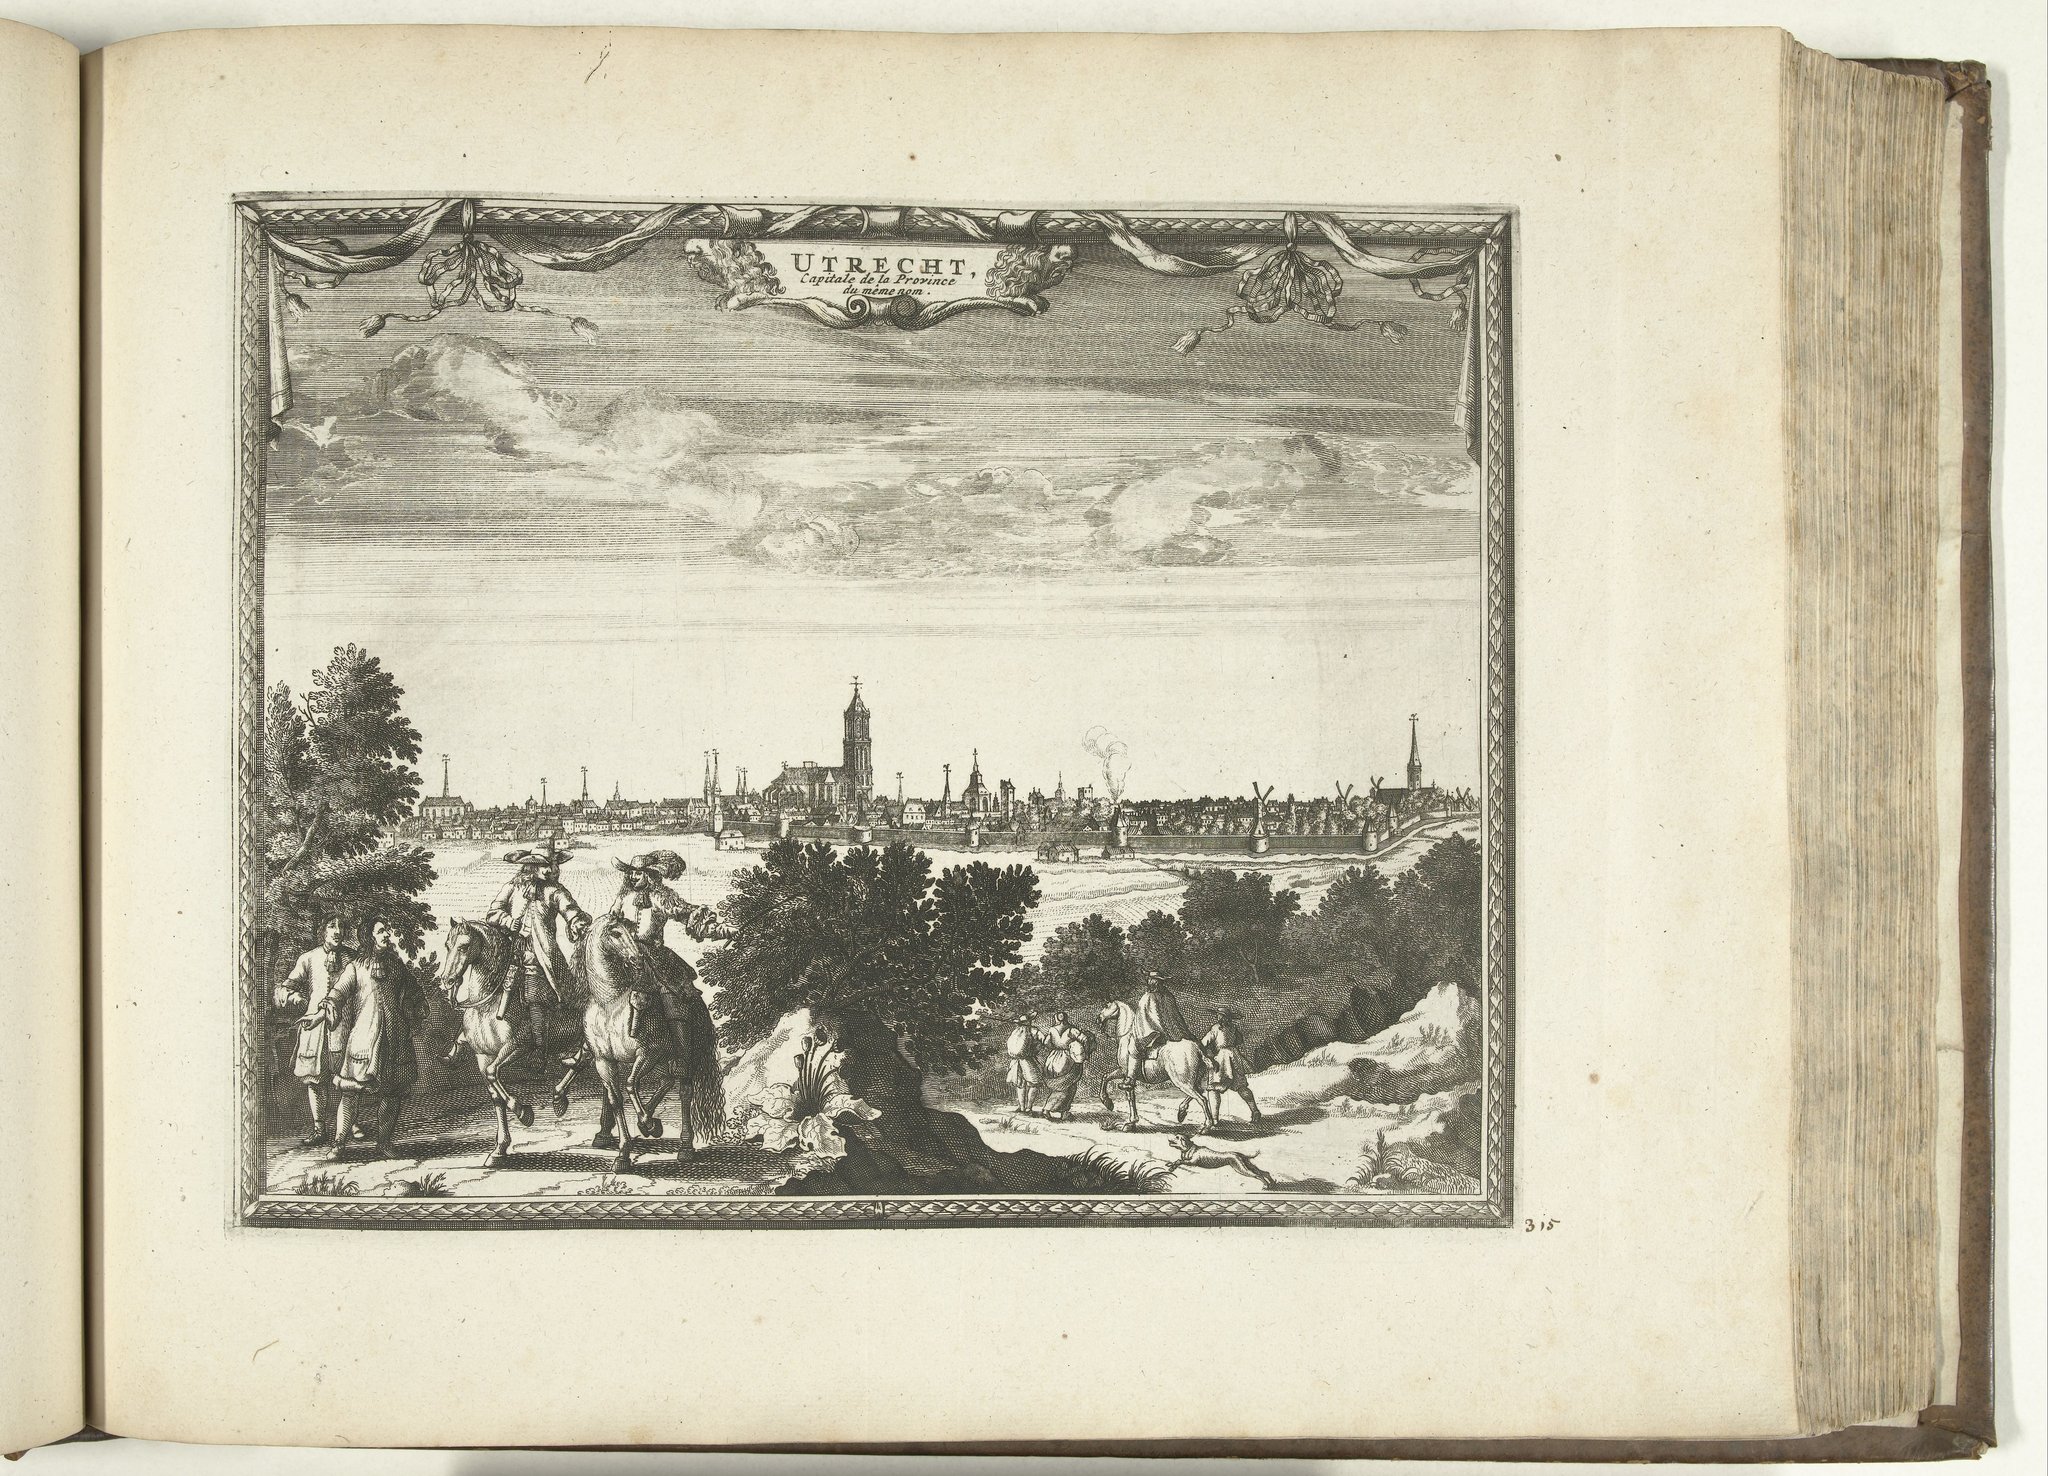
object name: print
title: Gezicht op Utrecht, 1726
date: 1726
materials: paper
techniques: etching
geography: northern netherlands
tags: utrecht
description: Gezicht op Utrecht, op de voorgrond enkele wandelaars en ruiters. Plaat nr. 315 in deel XIII van het prentwerk: Les Forces de l'Europe, Asie, Afrique et Amerique ... Comme aussi les Cartes des Côtes de France et d'Espagne uit 1726, dit tweede deel met 271 met de hand genummerde platen van vermaarde sterke steden en vestingen in het kader van de Spaanse Successieoorlog 1701-1713. Voor het merendeel zijn deze platen gekopieerd naar de anonieme Franse platen van vermaarde sterke steden en vestingen: in Les forces de l'Europe en in: Le theatre de la guerre, dans les Pays-Bas, beide oorspronkelijk uitgegeven door Nicolas de Fer te Parijs (1693-1697) in het kader van de Negenjarige Oorlog. Titel in het Frans.